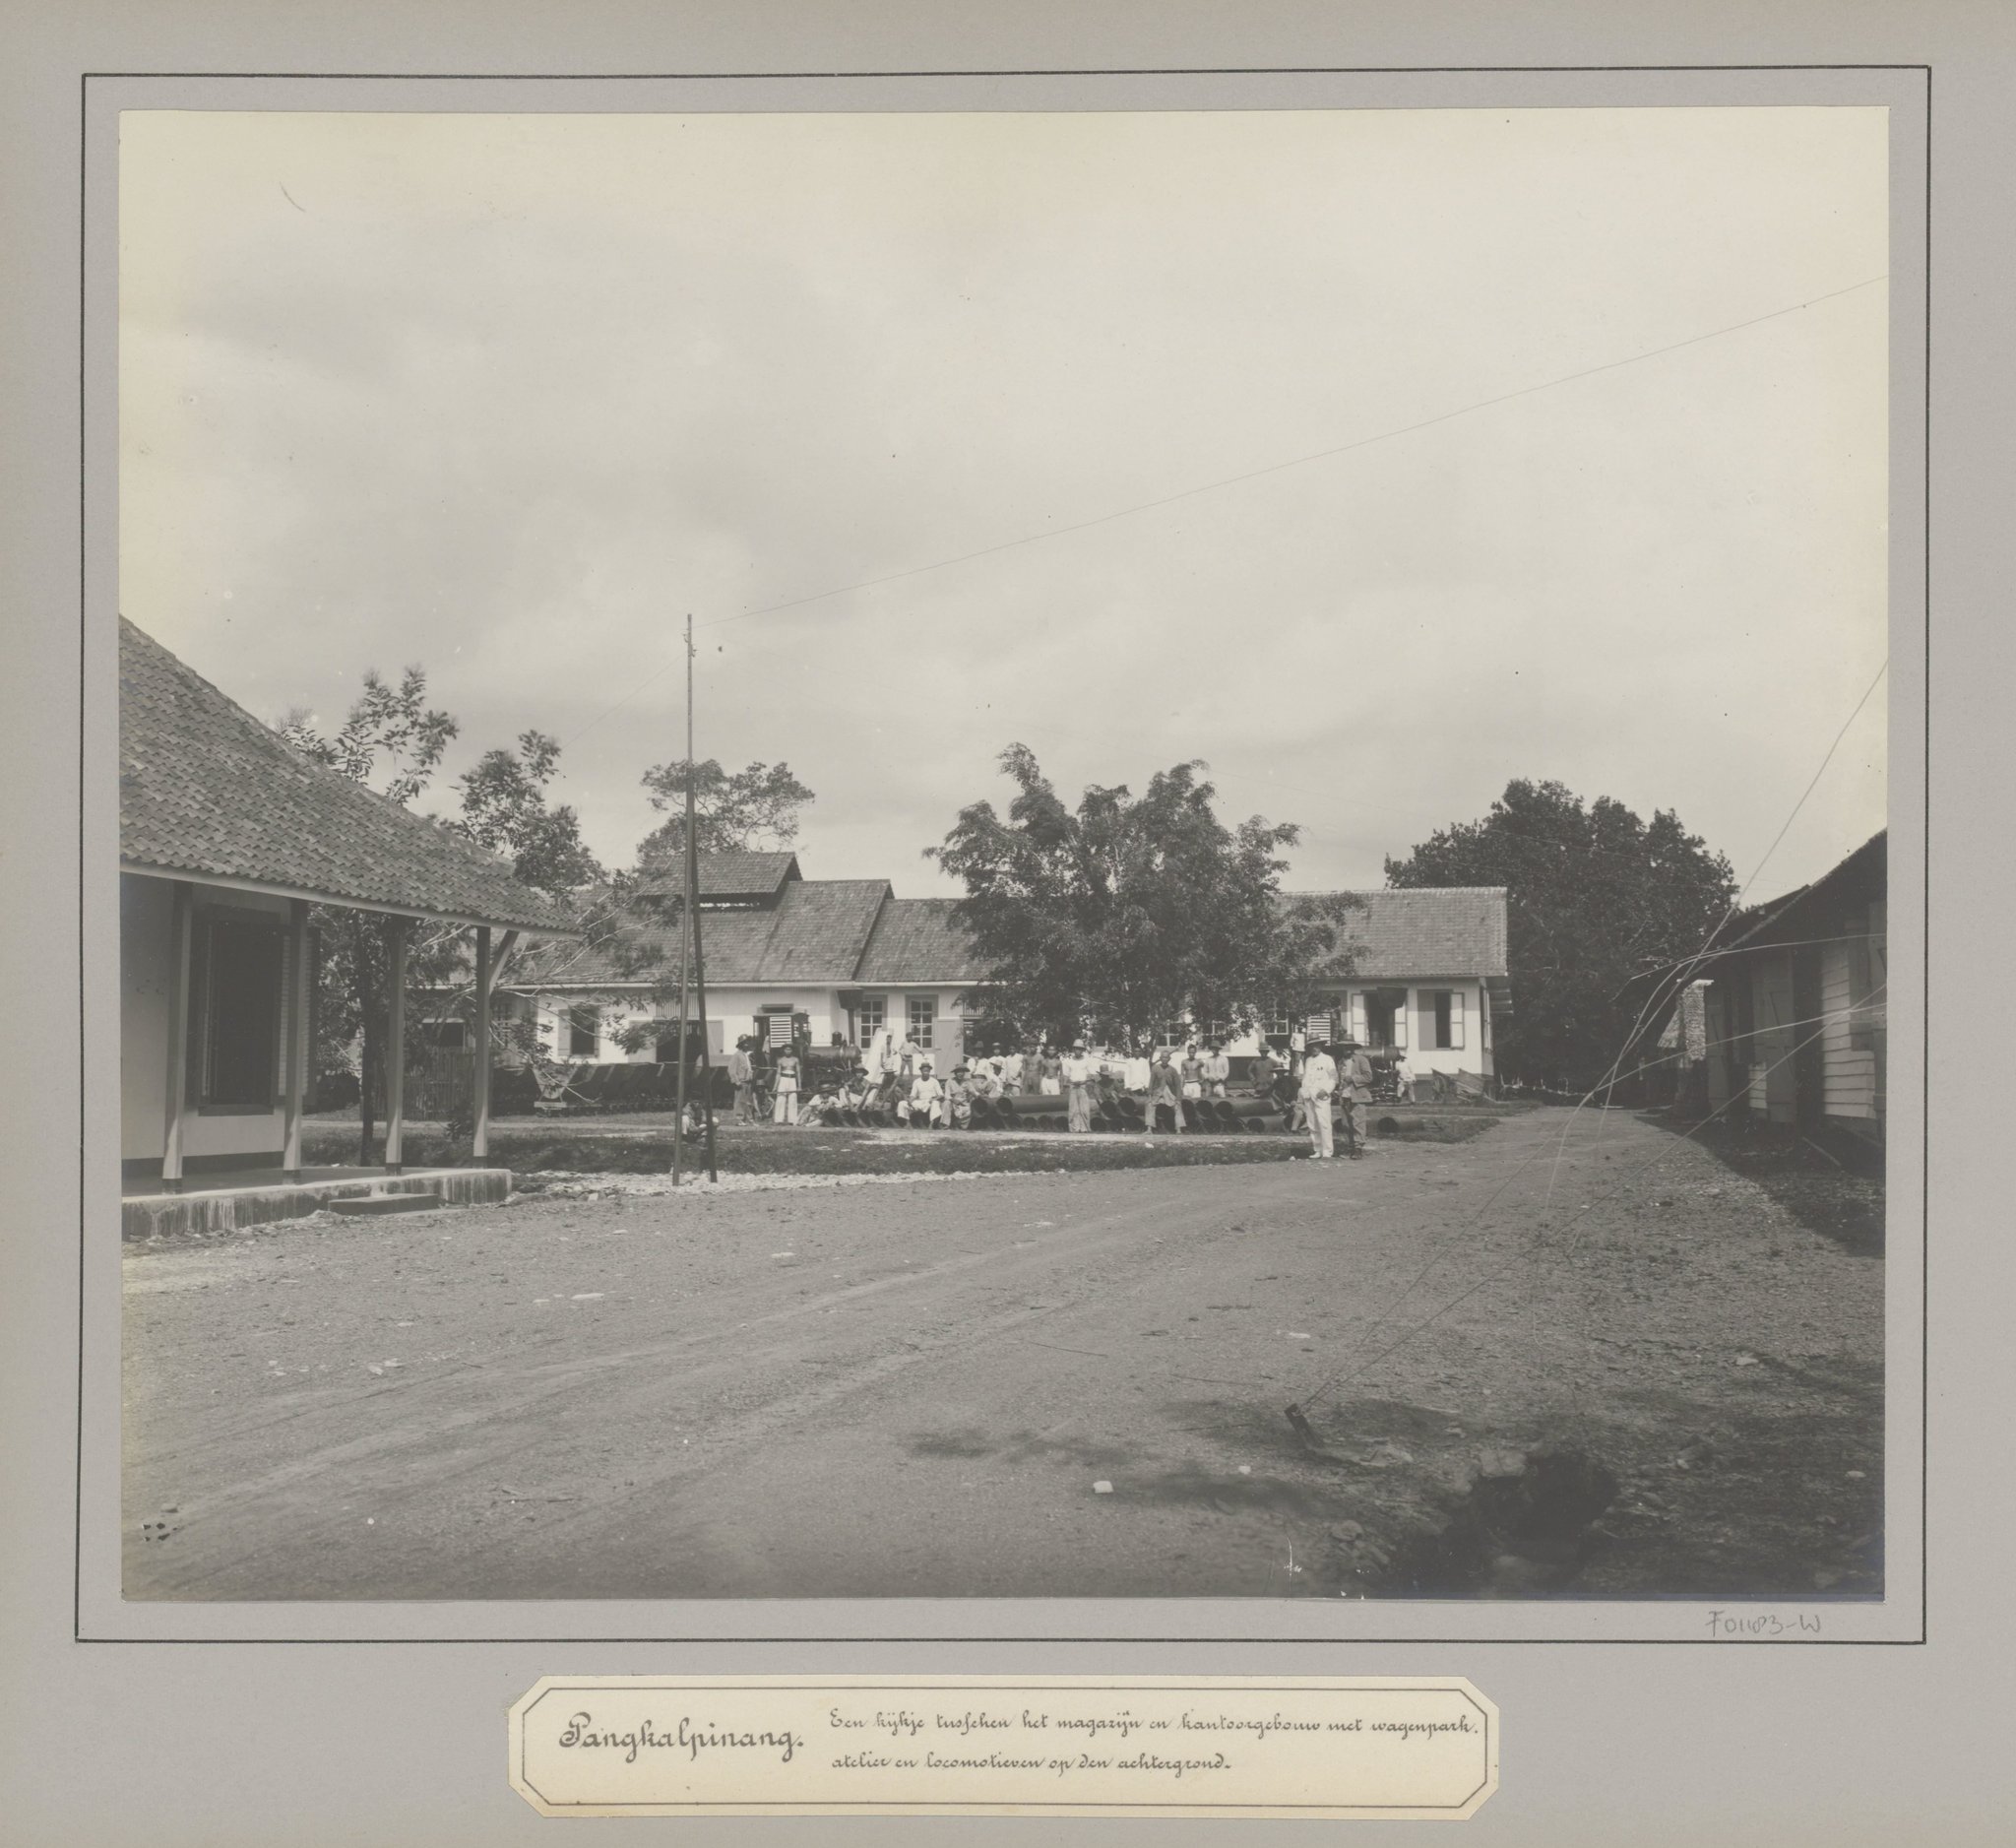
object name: photograph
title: Pangkalpinang. Een kijkje tusschen het magazijn en kantoor- gebouw met wagenpark, atelier en locomotieven op den achtergrond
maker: Anonymous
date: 1900-1920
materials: photographic support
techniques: gelatin silver print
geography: pangkalpinang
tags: mining, minerals and metals: tin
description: Onderdeel van Fotoalbum over de tinwinning op Bangka.